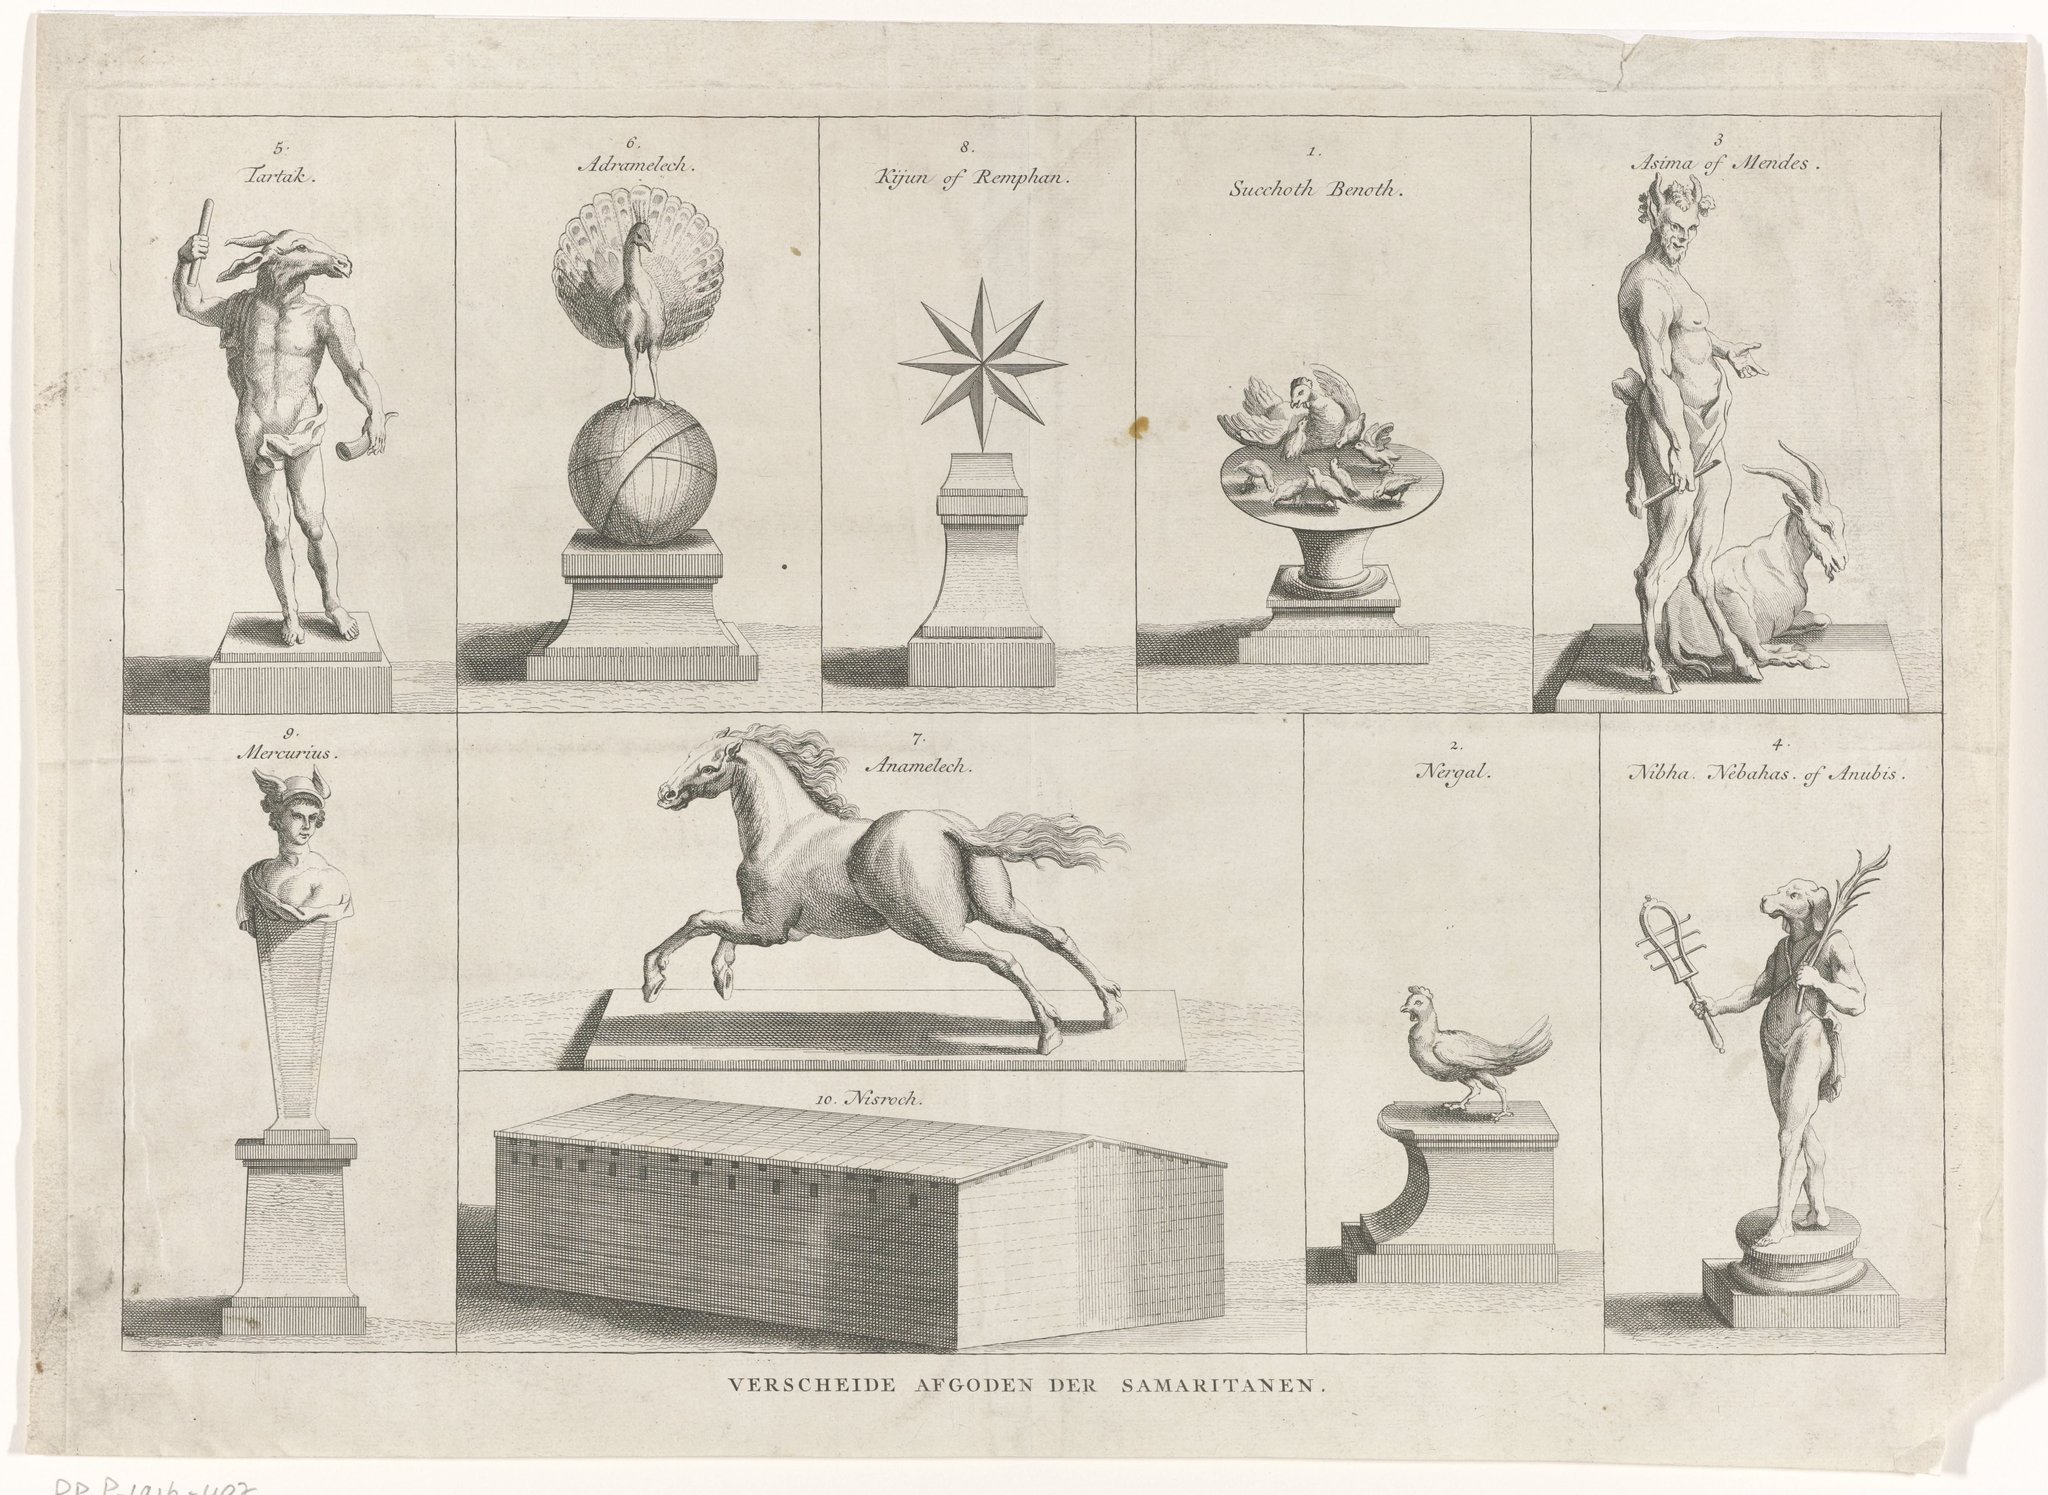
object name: print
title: Verscheide afgoden der Samaritanen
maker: Anonymous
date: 1700-1800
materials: paper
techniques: engraving, etching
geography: netherlands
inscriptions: collector's mark: Lugt 2228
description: Tien genummerde voorstellingen van godenbeelden van de Samaritanen.